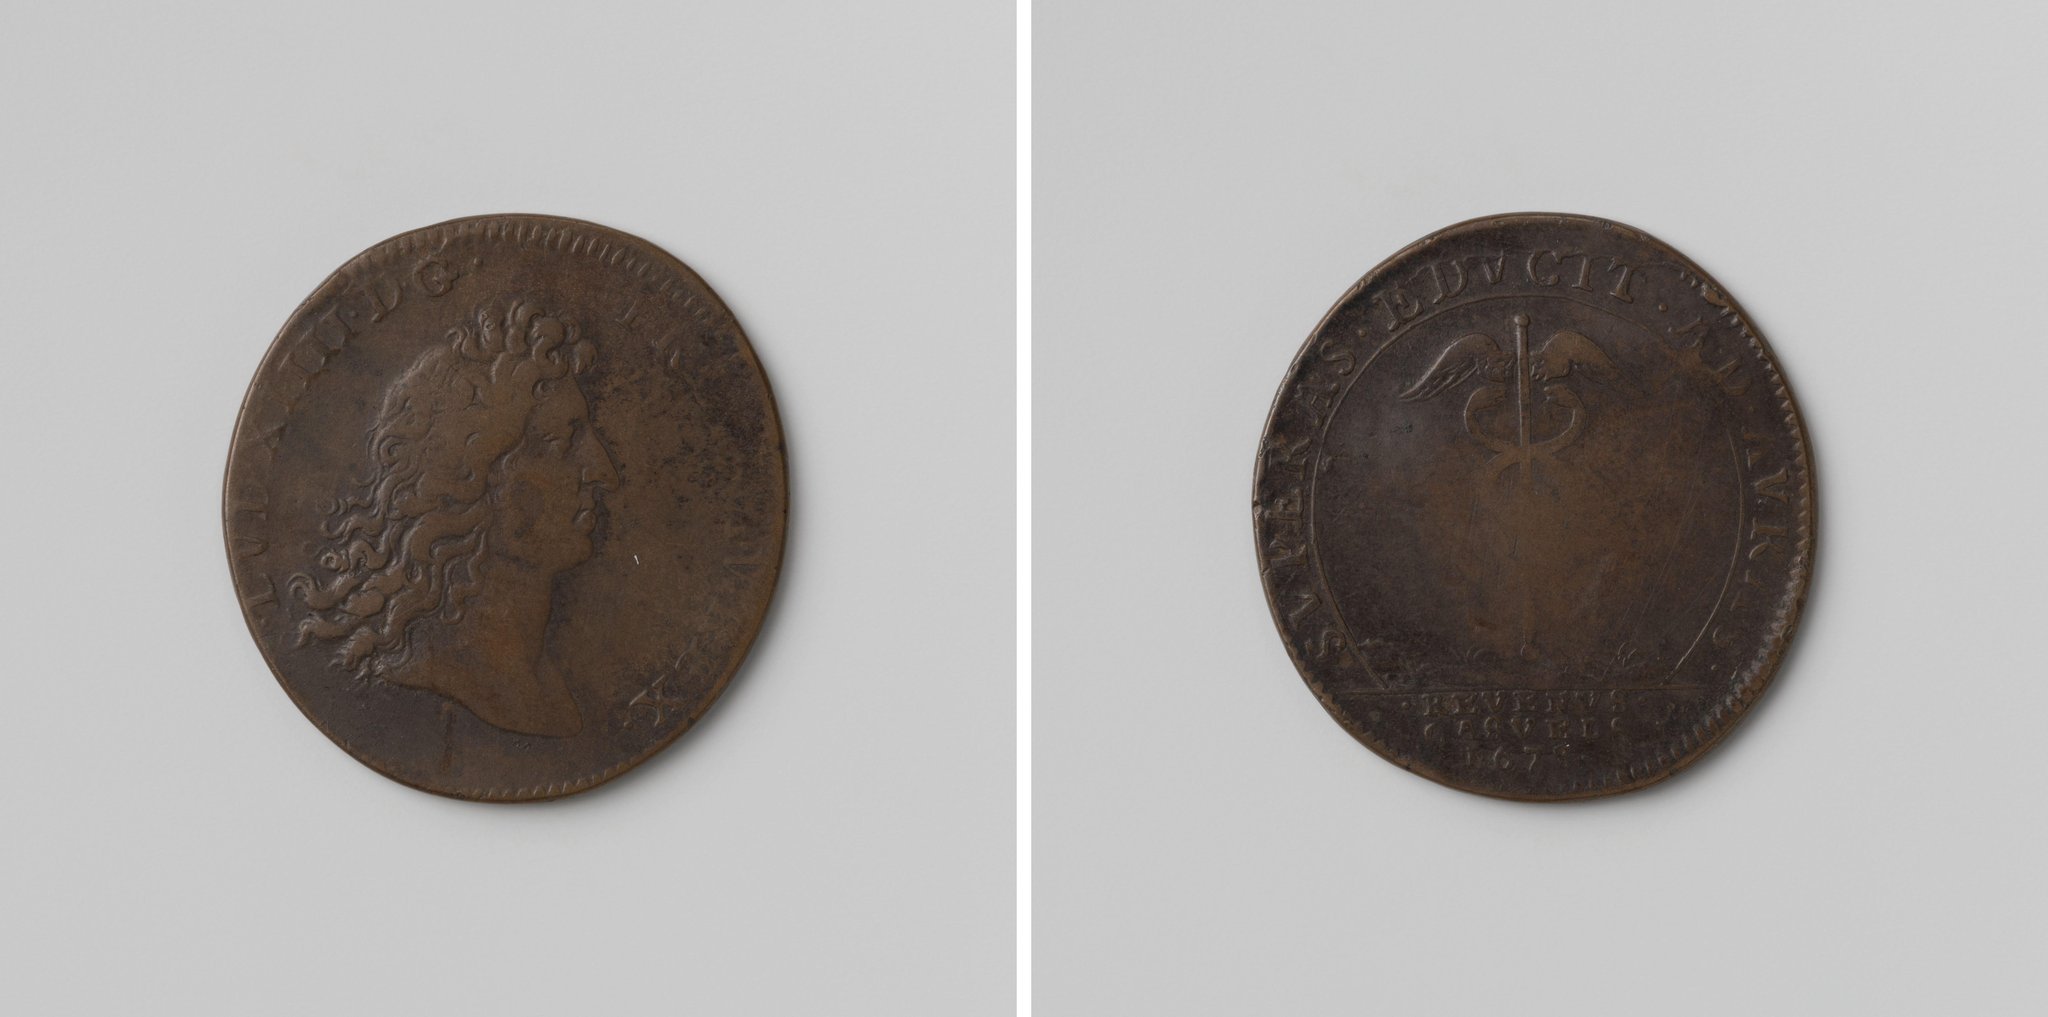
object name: jeton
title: Vrede van Nijmegen, rekenpenning geslagen ter ere van Lodewijk XIV, koning van Frankrijk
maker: Anonymous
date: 1678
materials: copper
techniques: striking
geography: france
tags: lodewijk xiv (koning van frankrijk), nijmegen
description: Koperen penning. Voorzijde: borststuk man binnen omschrift. Keerzijde: gevleugelde Mercuriusstaf binnen omschrift; afsnede: opschrift